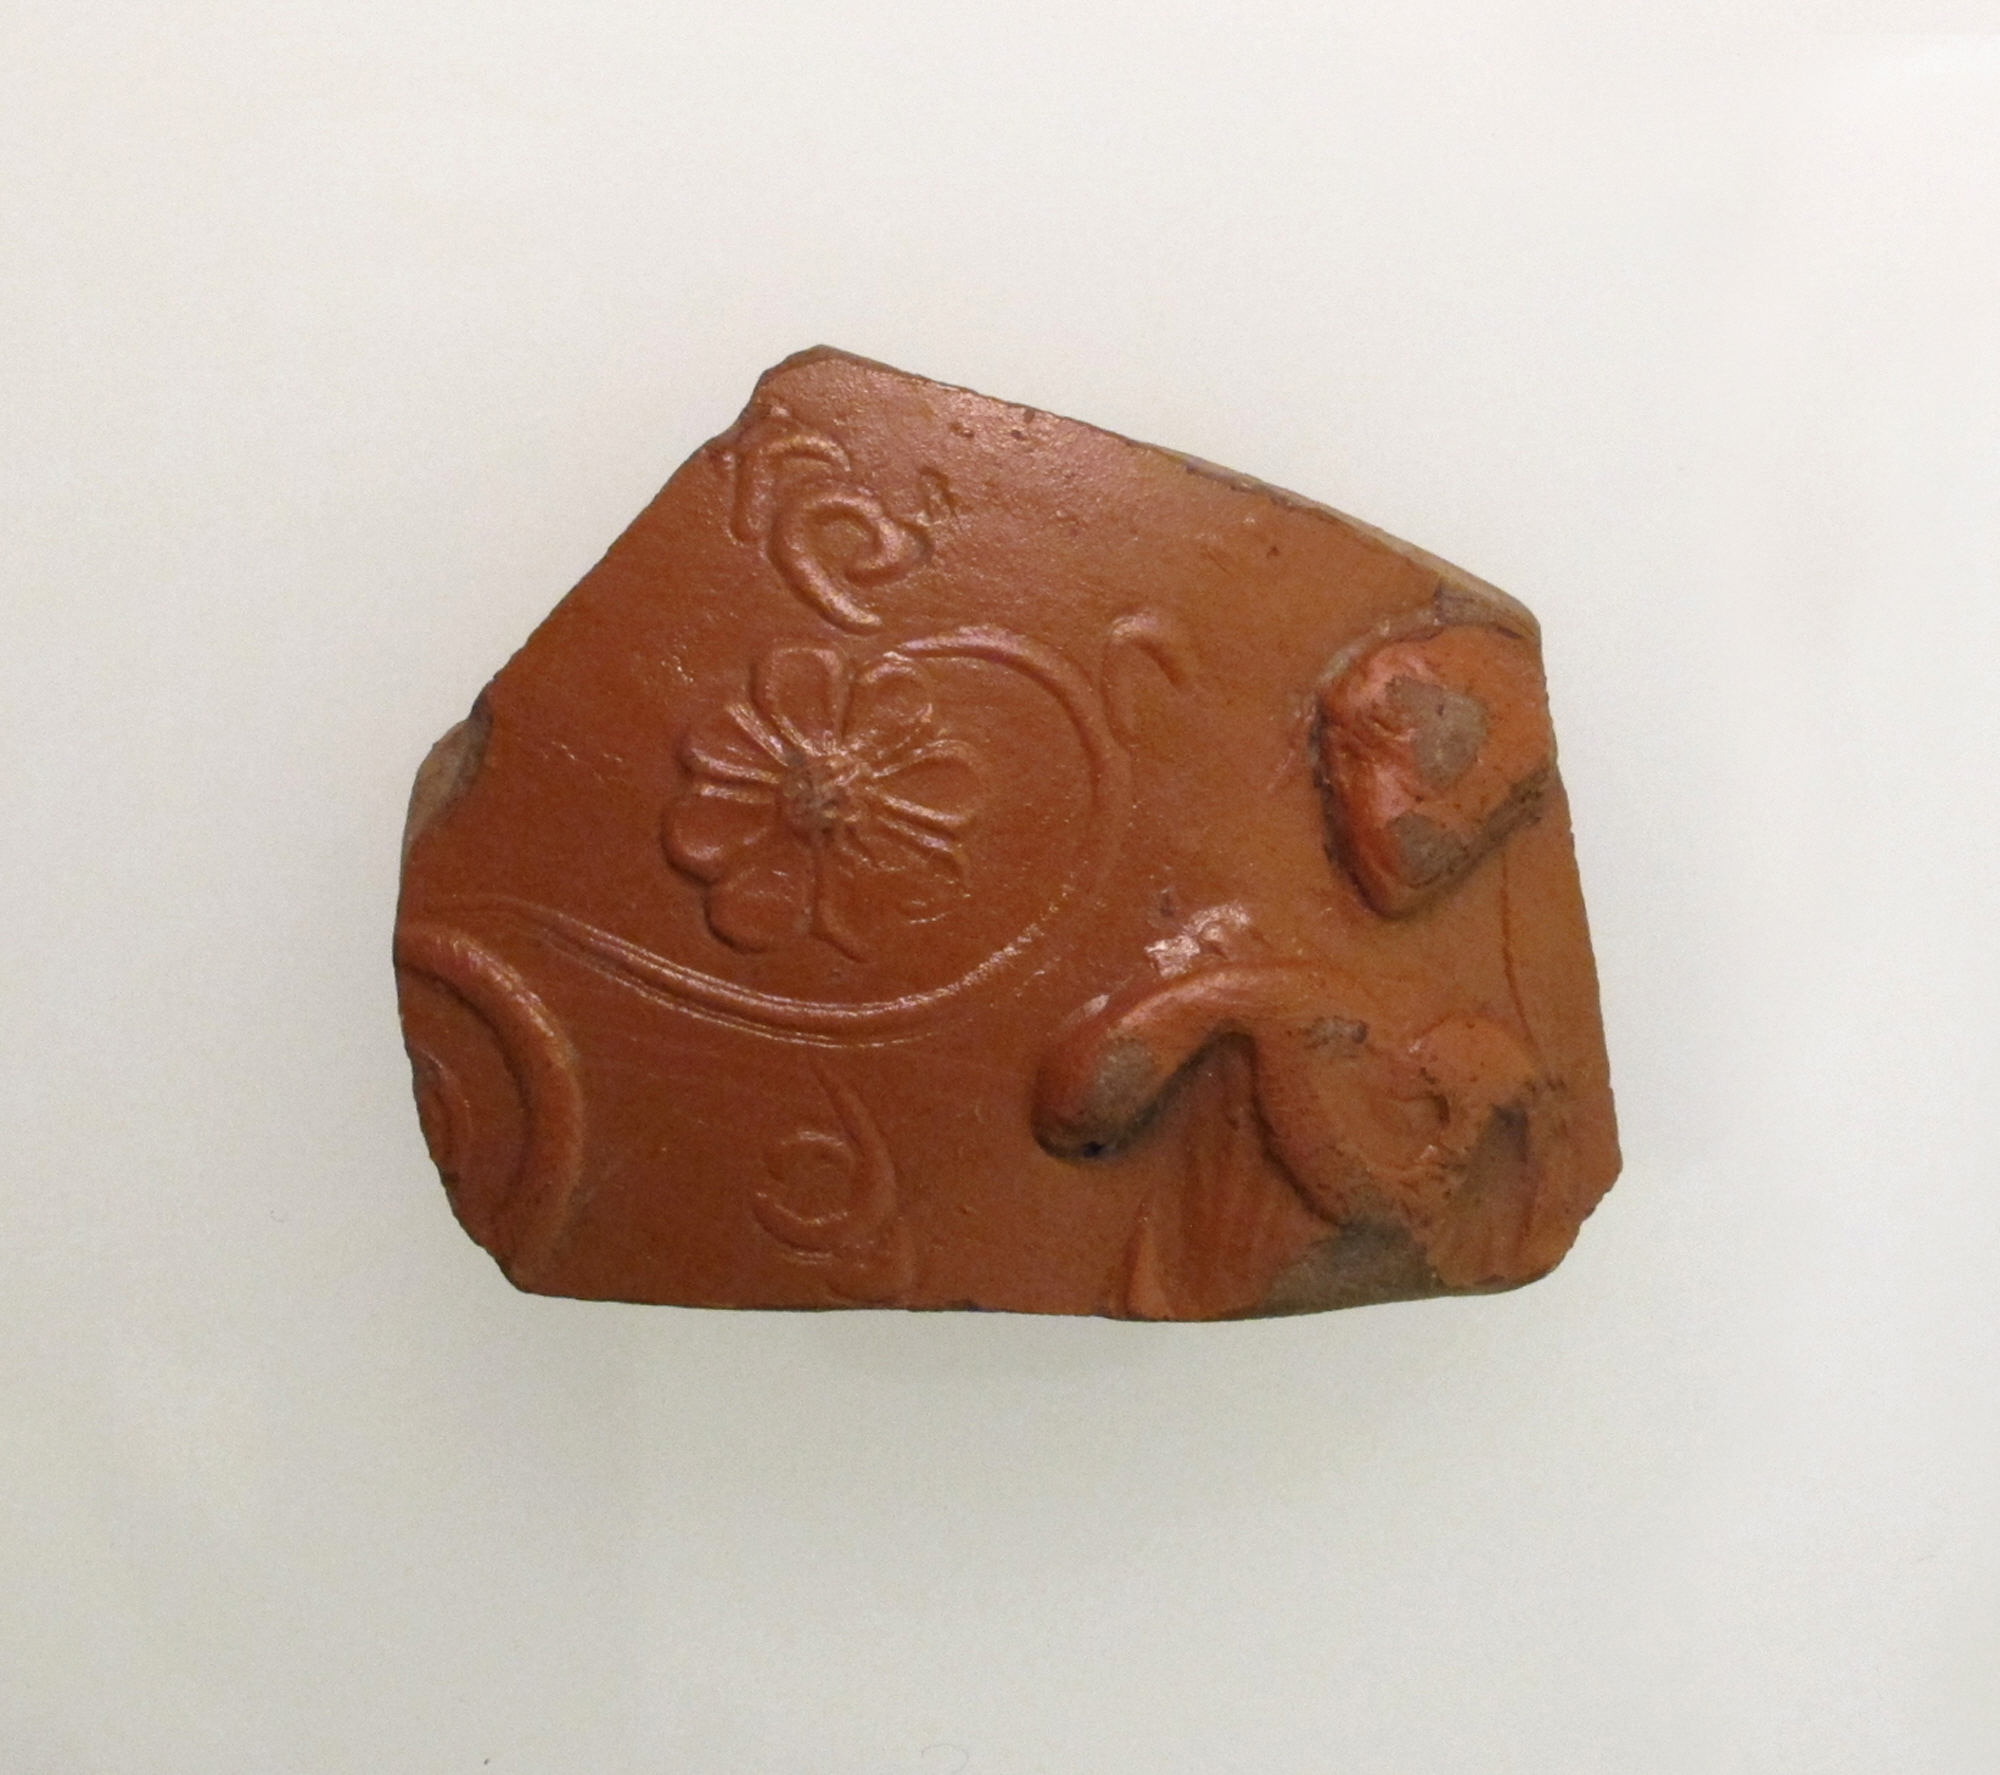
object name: vase fragment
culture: roman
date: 670 BCE-330 CE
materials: terracotta